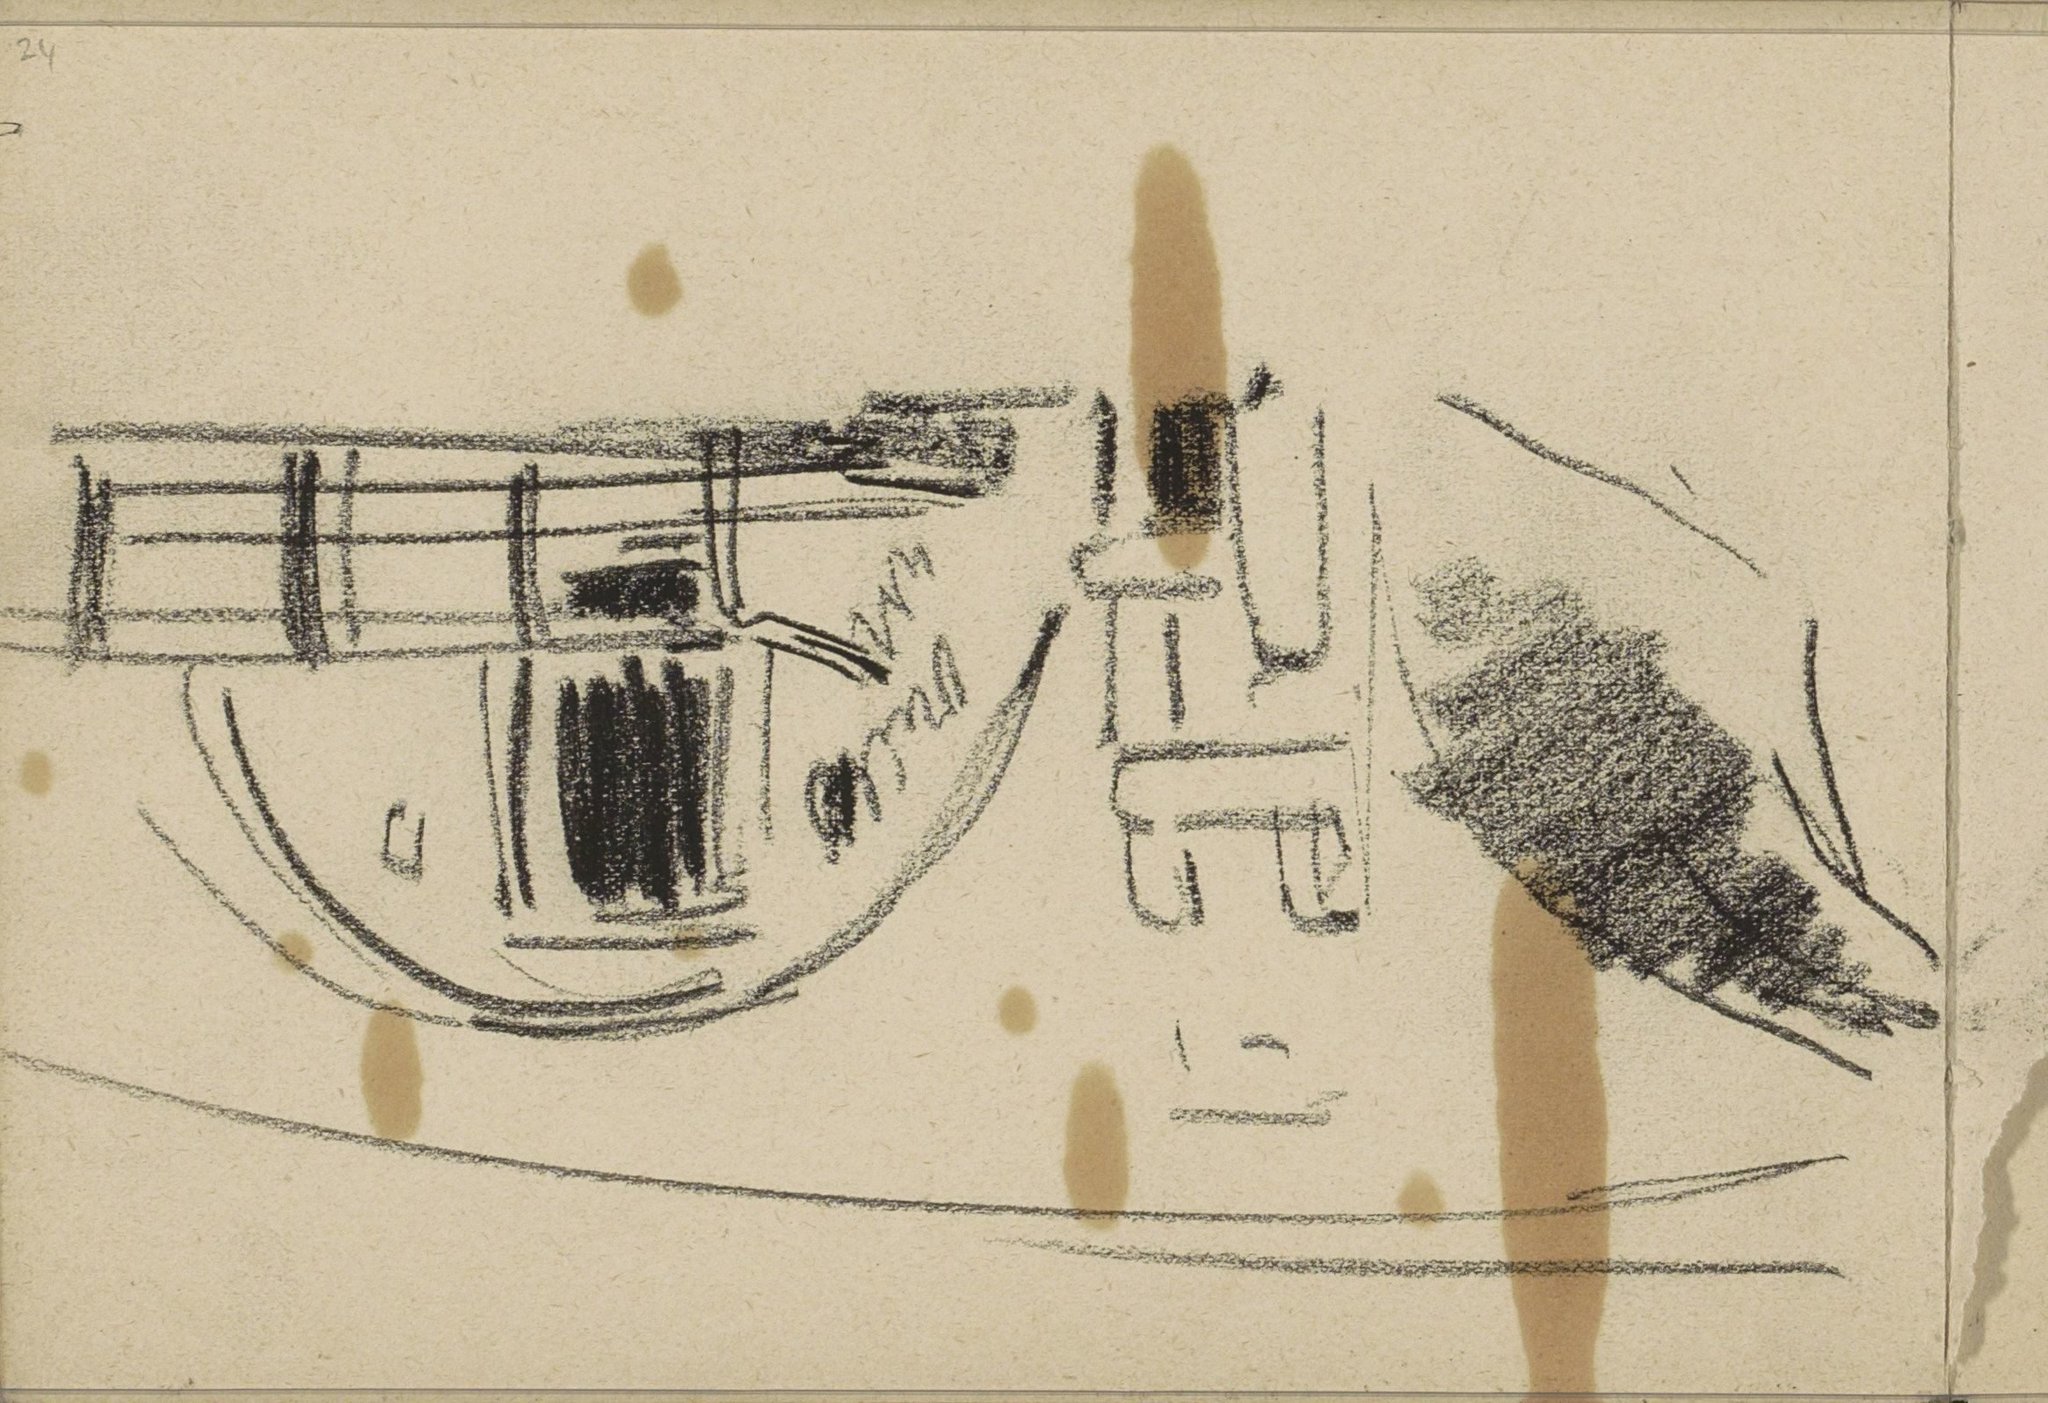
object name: sketchbook leaf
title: Gezicht op de brug Lekkeresluis te Amsterdam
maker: willem witsen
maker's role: draughtsman, painter, print maker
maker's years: 1860-1923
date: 1903-1904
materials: chalk, paper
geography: amsterdam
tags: bridge in city across river, canal, etc.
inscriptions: : ‘[...]’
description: Pagina 24 uit een schetsboek met 16 bladen.